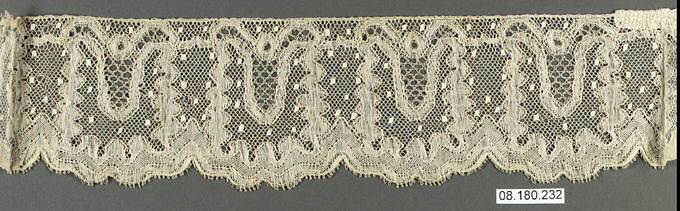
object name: fragment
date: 1801-1833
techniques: lace